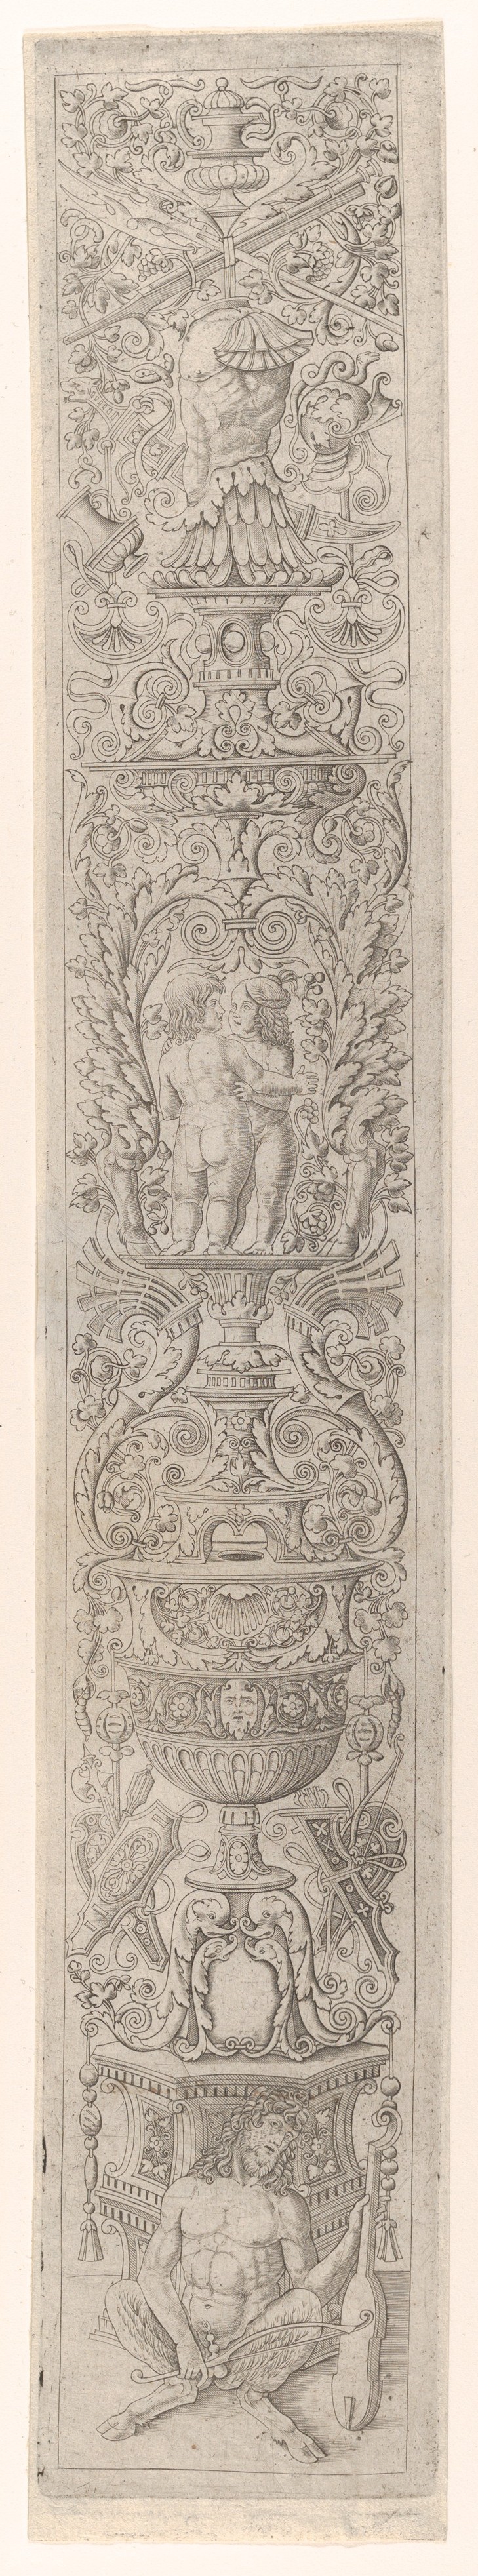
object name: print ornament architecture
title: A Satyr Holding a Violin, from Twelve Ornamental Panels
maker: giovanni antonio da brescia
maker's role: artist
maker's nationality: italian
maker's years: 1490-1525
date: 1490-1515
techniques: engraving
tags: ornament,children,violins,satyrs